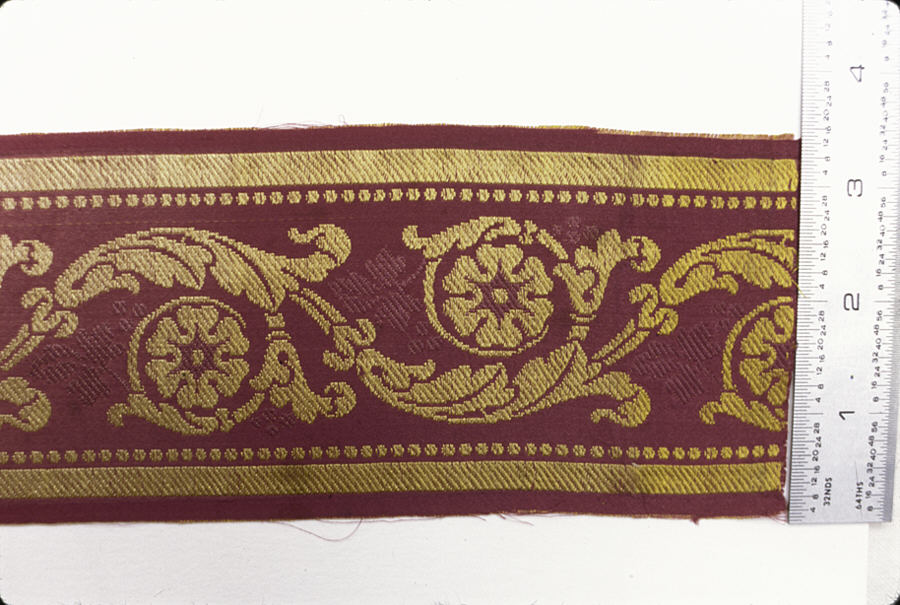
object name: piece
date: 1801-1833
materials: silk